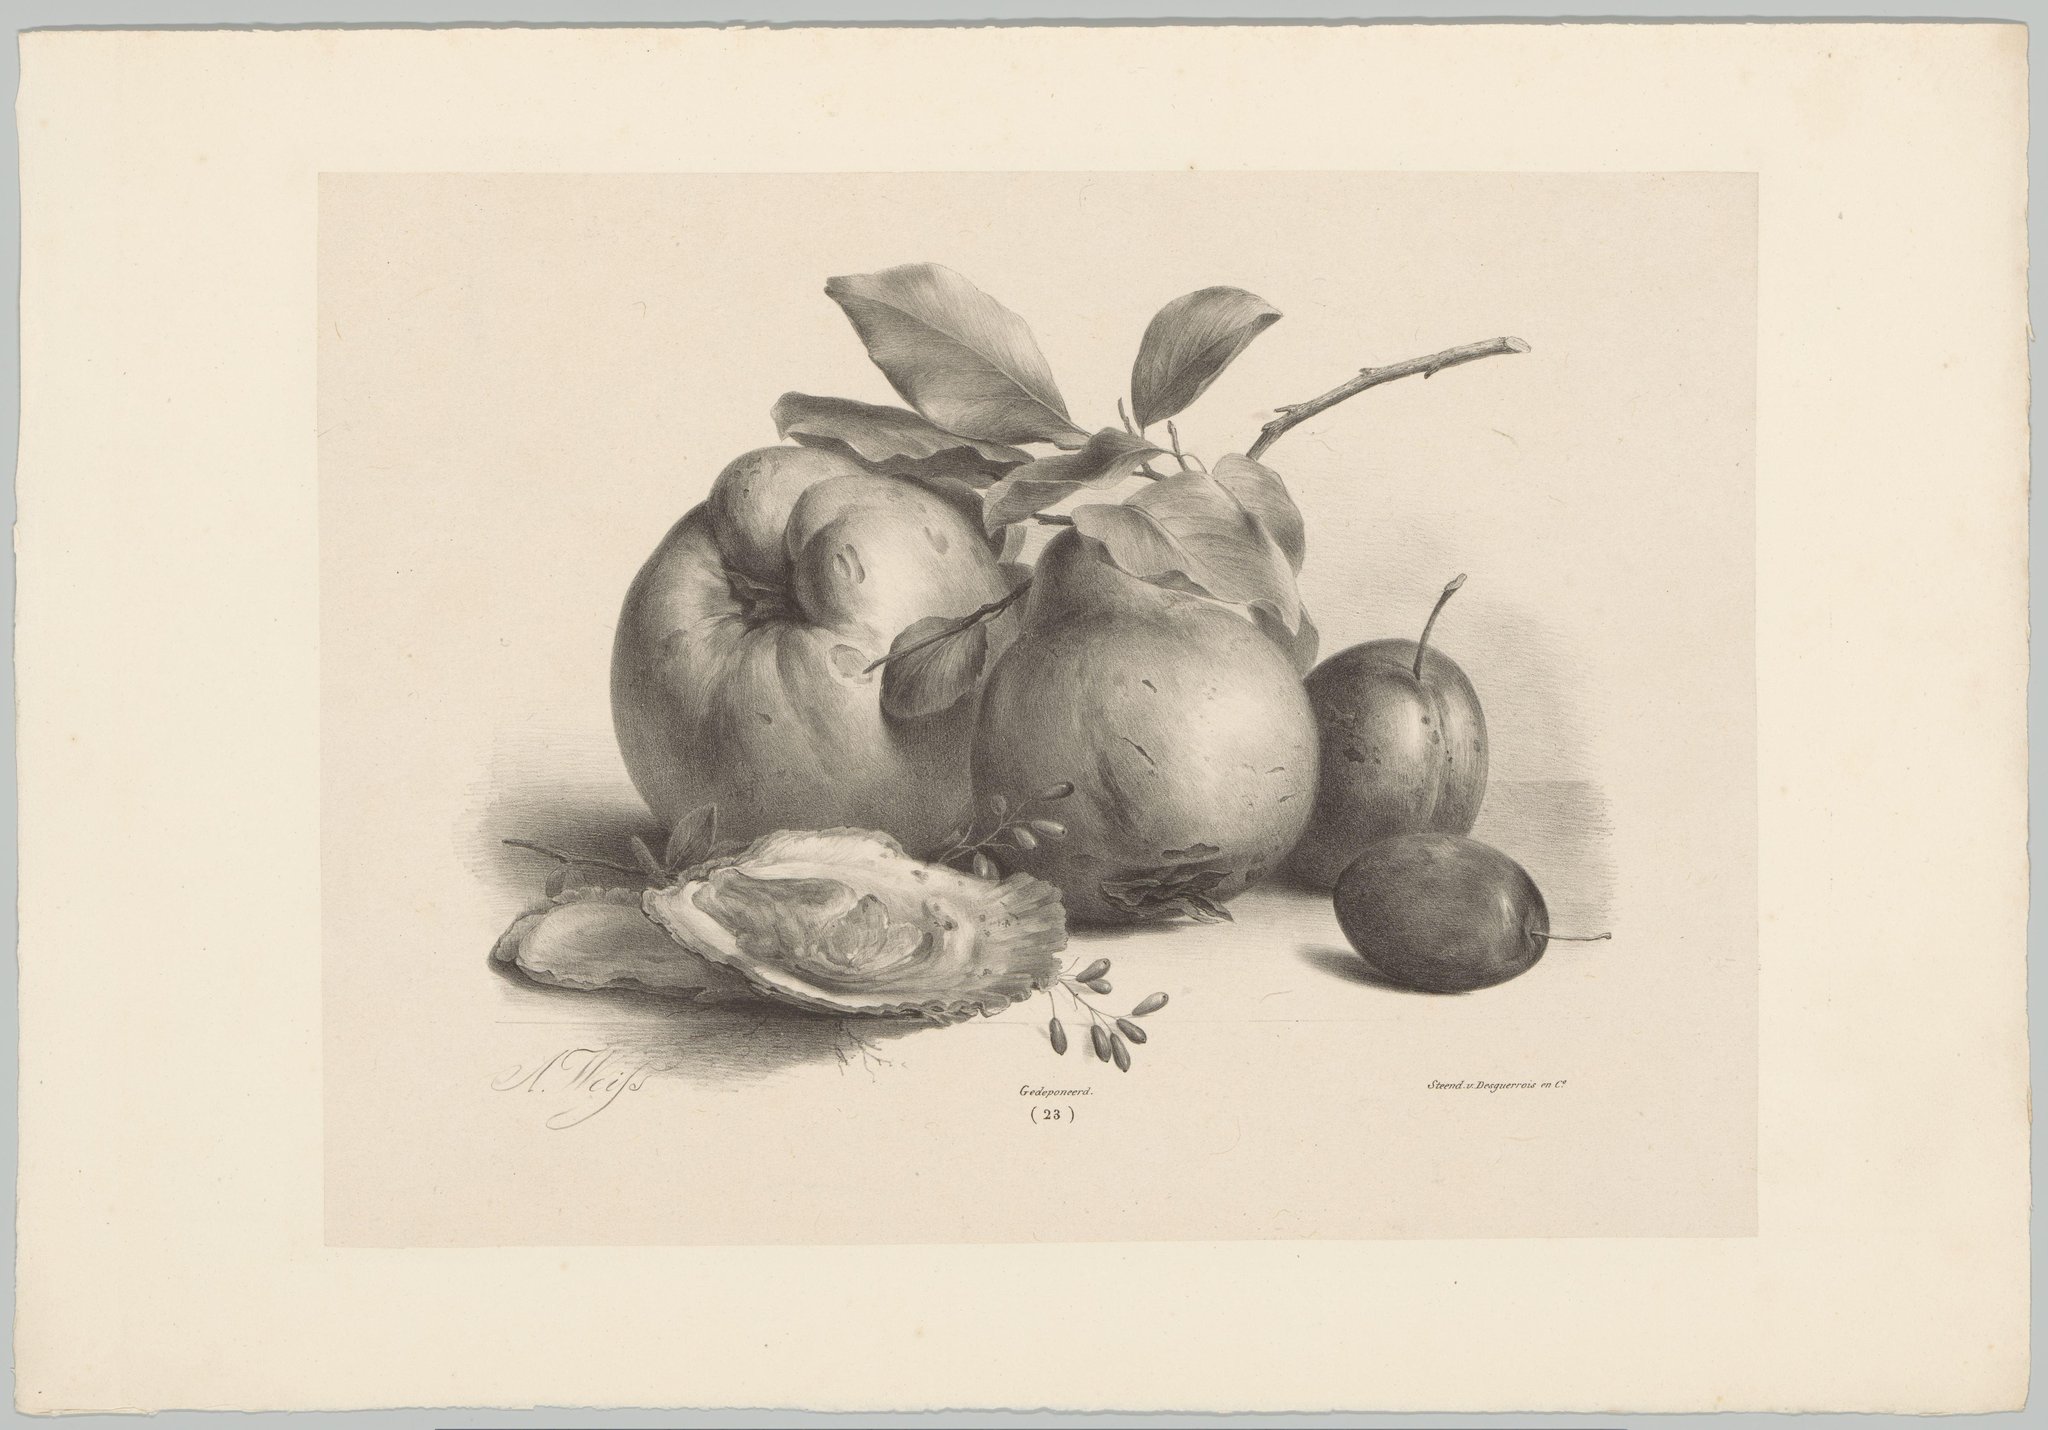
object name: print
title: Fruit, pruimen en oesters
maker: anton weiss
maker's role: draughtsman, print maker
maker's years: 1801-1851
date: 1836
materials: paper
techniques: lithograph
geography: amsterdam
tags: molluscs: oyster, fruits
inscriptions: collector's mark: Lugt 2228, : ‘Gedeponeerd.’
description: Onderdeel van een omslag met een serie van eenenveertig lithografieën van bloemen en fruit.